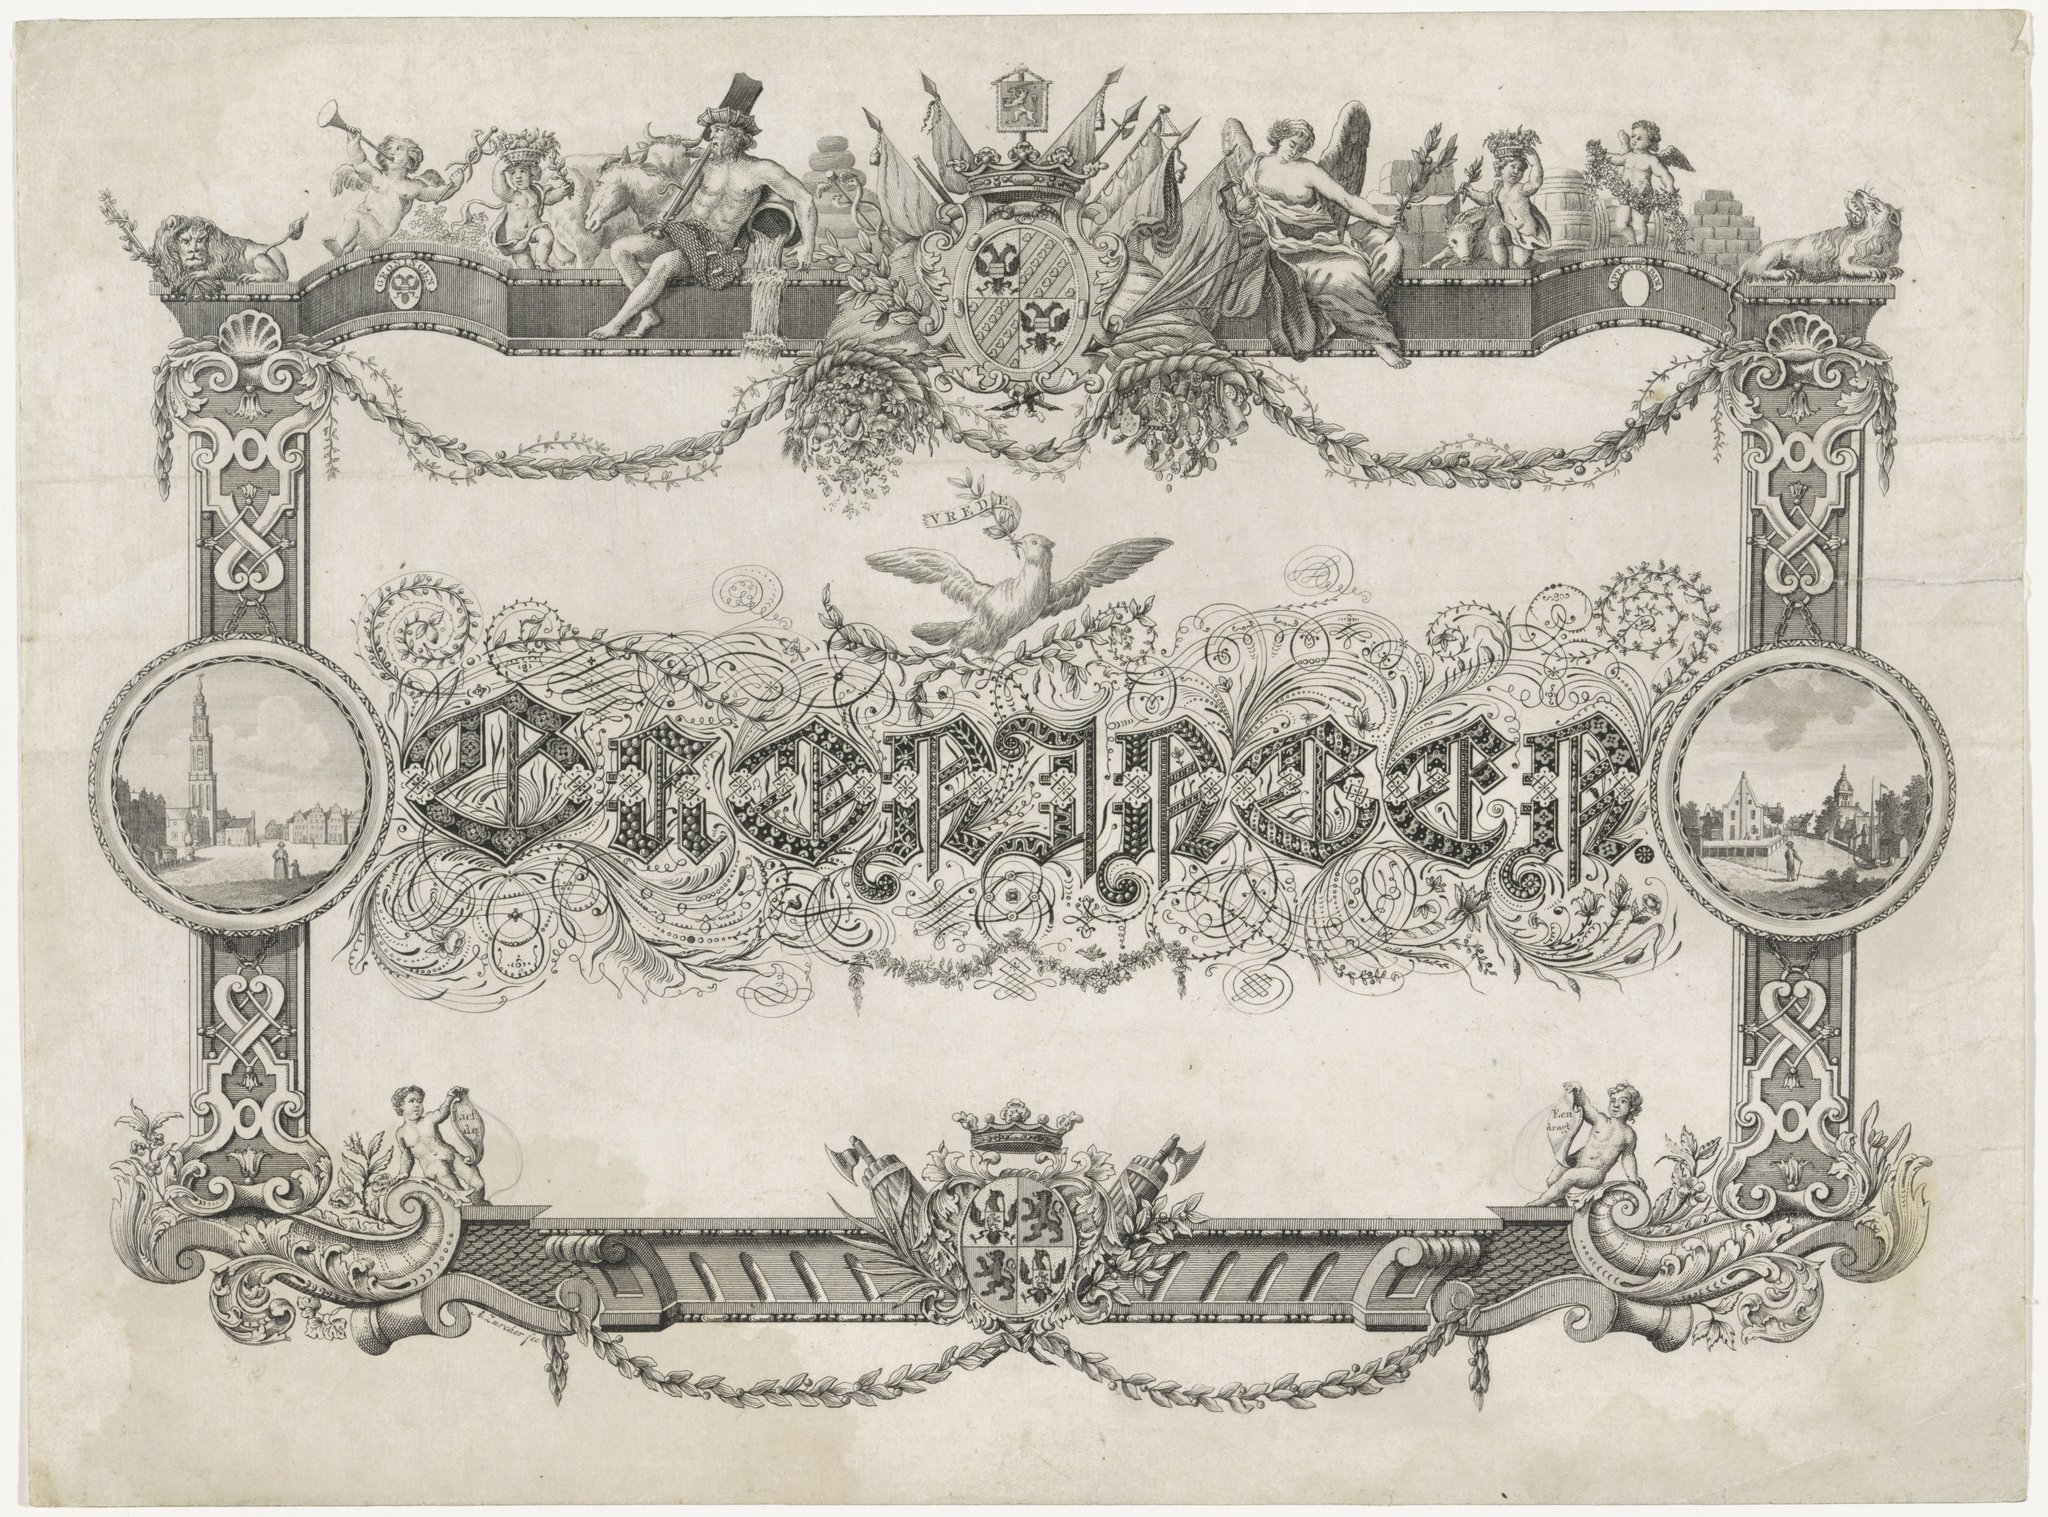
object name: print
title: Kalligrafieën van de zeven provincies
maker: antoni zürcher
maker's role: print maker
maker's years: 1754-1837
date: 1790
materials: paper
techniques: calligraphy, engraving, etching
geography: northern netherlands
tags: calligraphy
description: Kalligrafie van de naam van de provincie Groningen. Binnen een kader met het provinciewapen, allegorische en mythologische figuren, wapens van de belangrijkste steden en twee topografische gezichten. Hier: de Grote Markt te Groningen en Appingedam. Onderdeel van een serie van zeven kalligrafieën van de provincies.